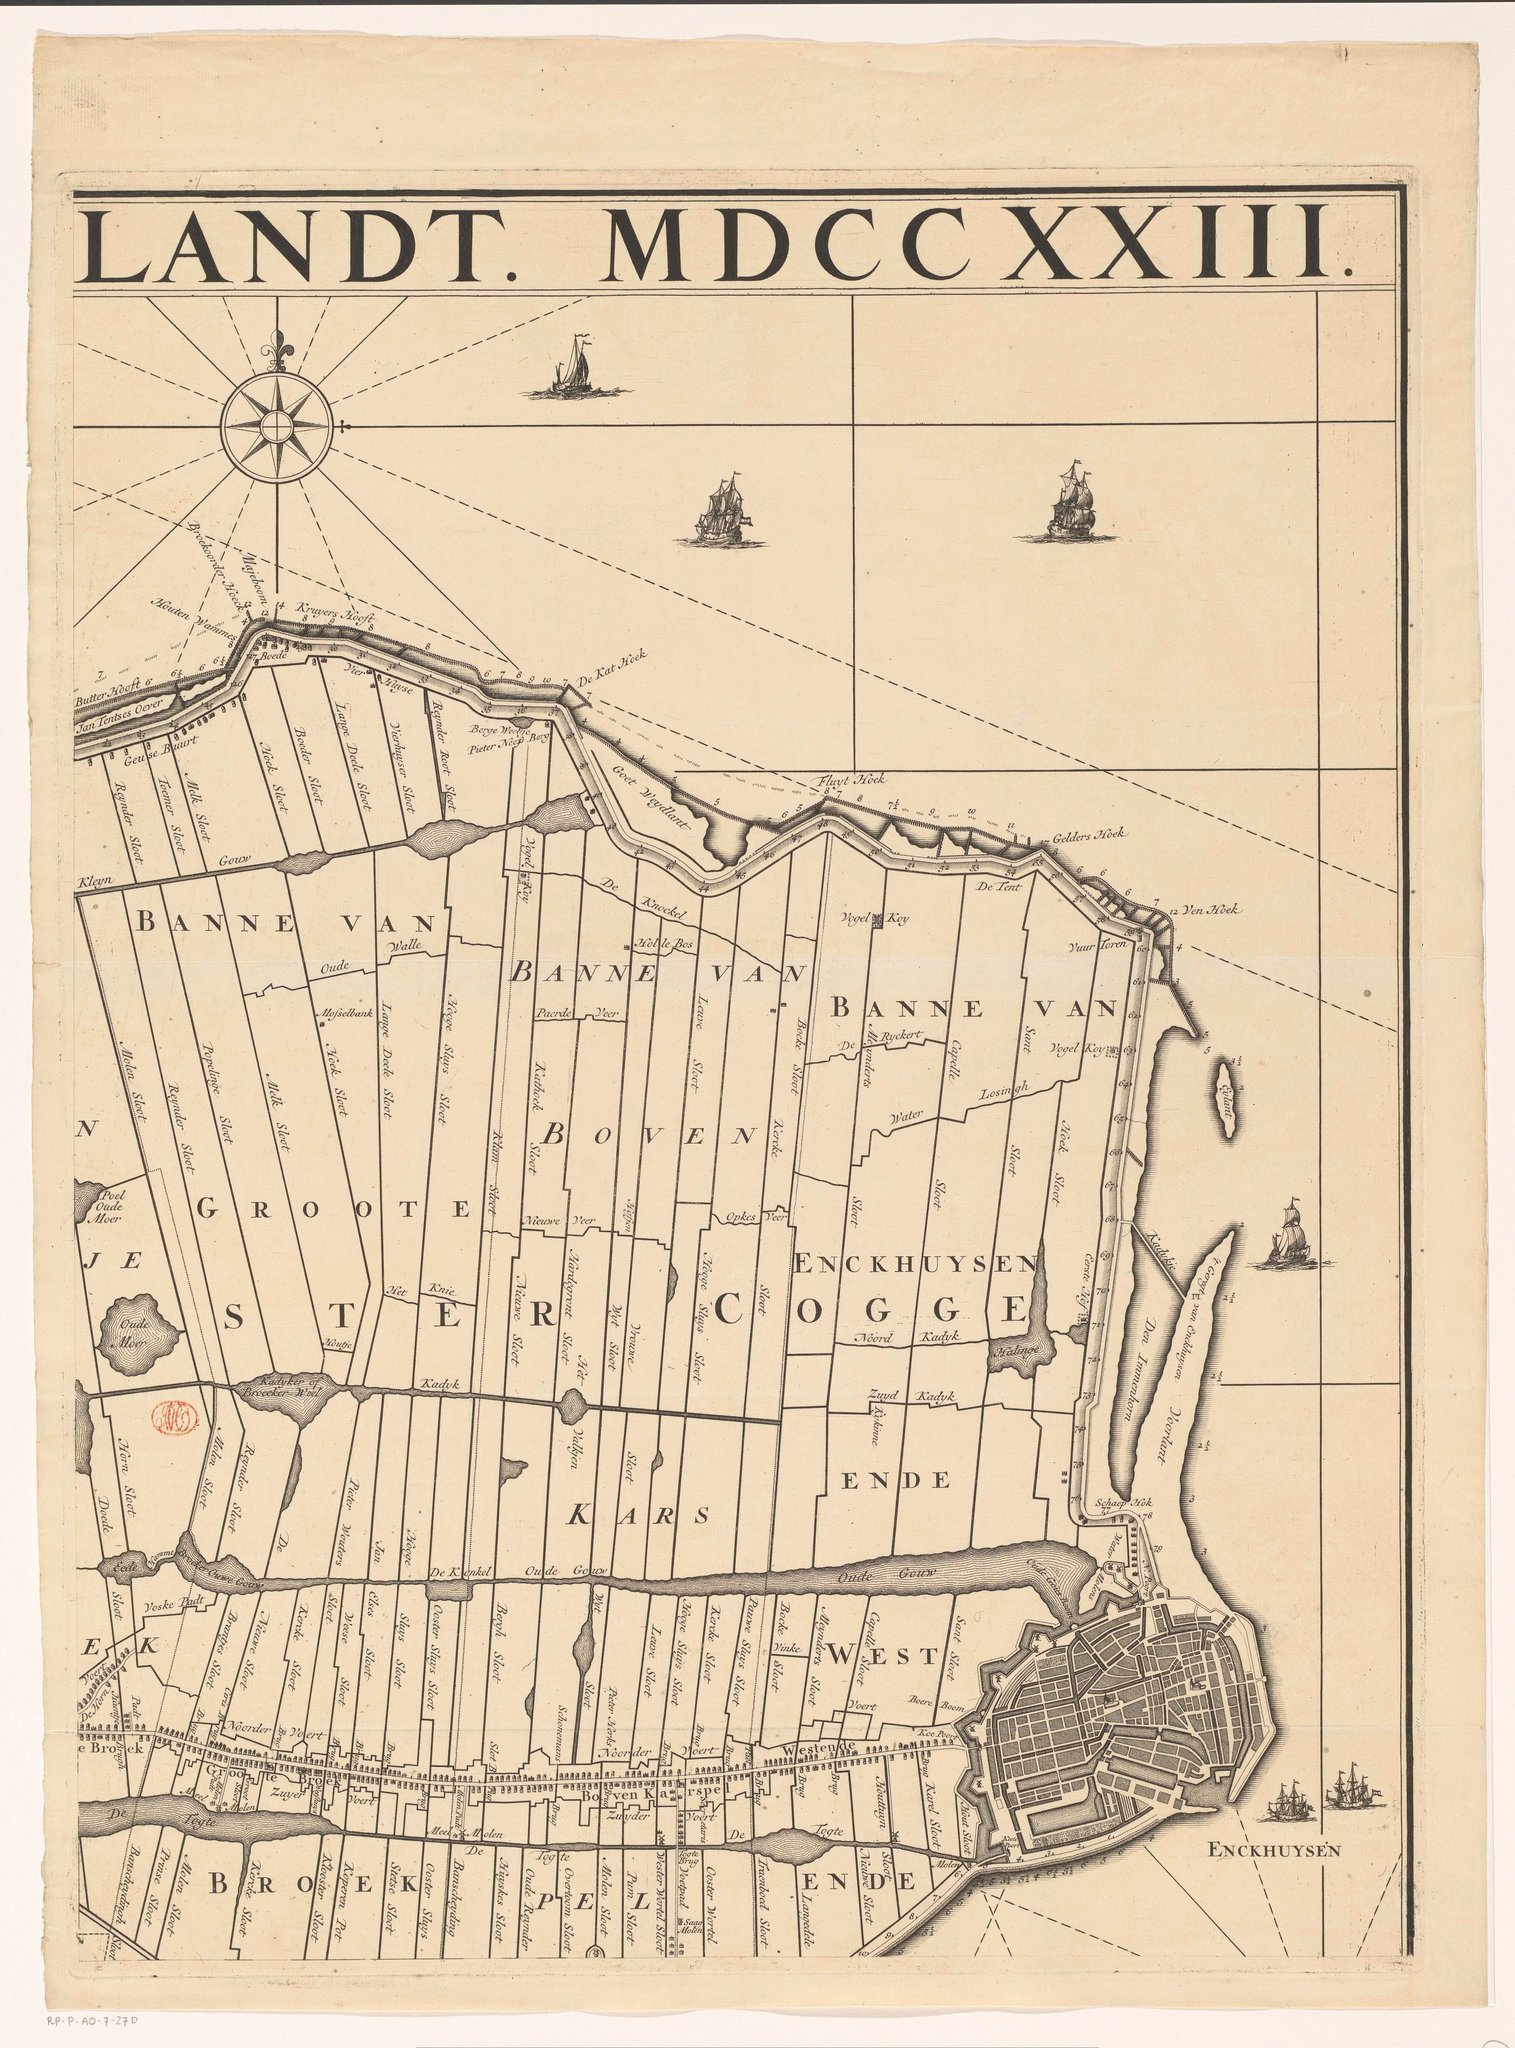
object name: print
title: Nieuwe kaarte van het dyckgraafschap van Dregterlandt. MDCCXXIII.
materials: paper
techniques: engraving, etching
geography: hem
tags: maps of separate countries or regions, polder, reclaimed land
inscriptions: collector's mark: Lugt 195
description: Deel (vierde van boven) van een kaart van het dijkgraafschap Drechterland.